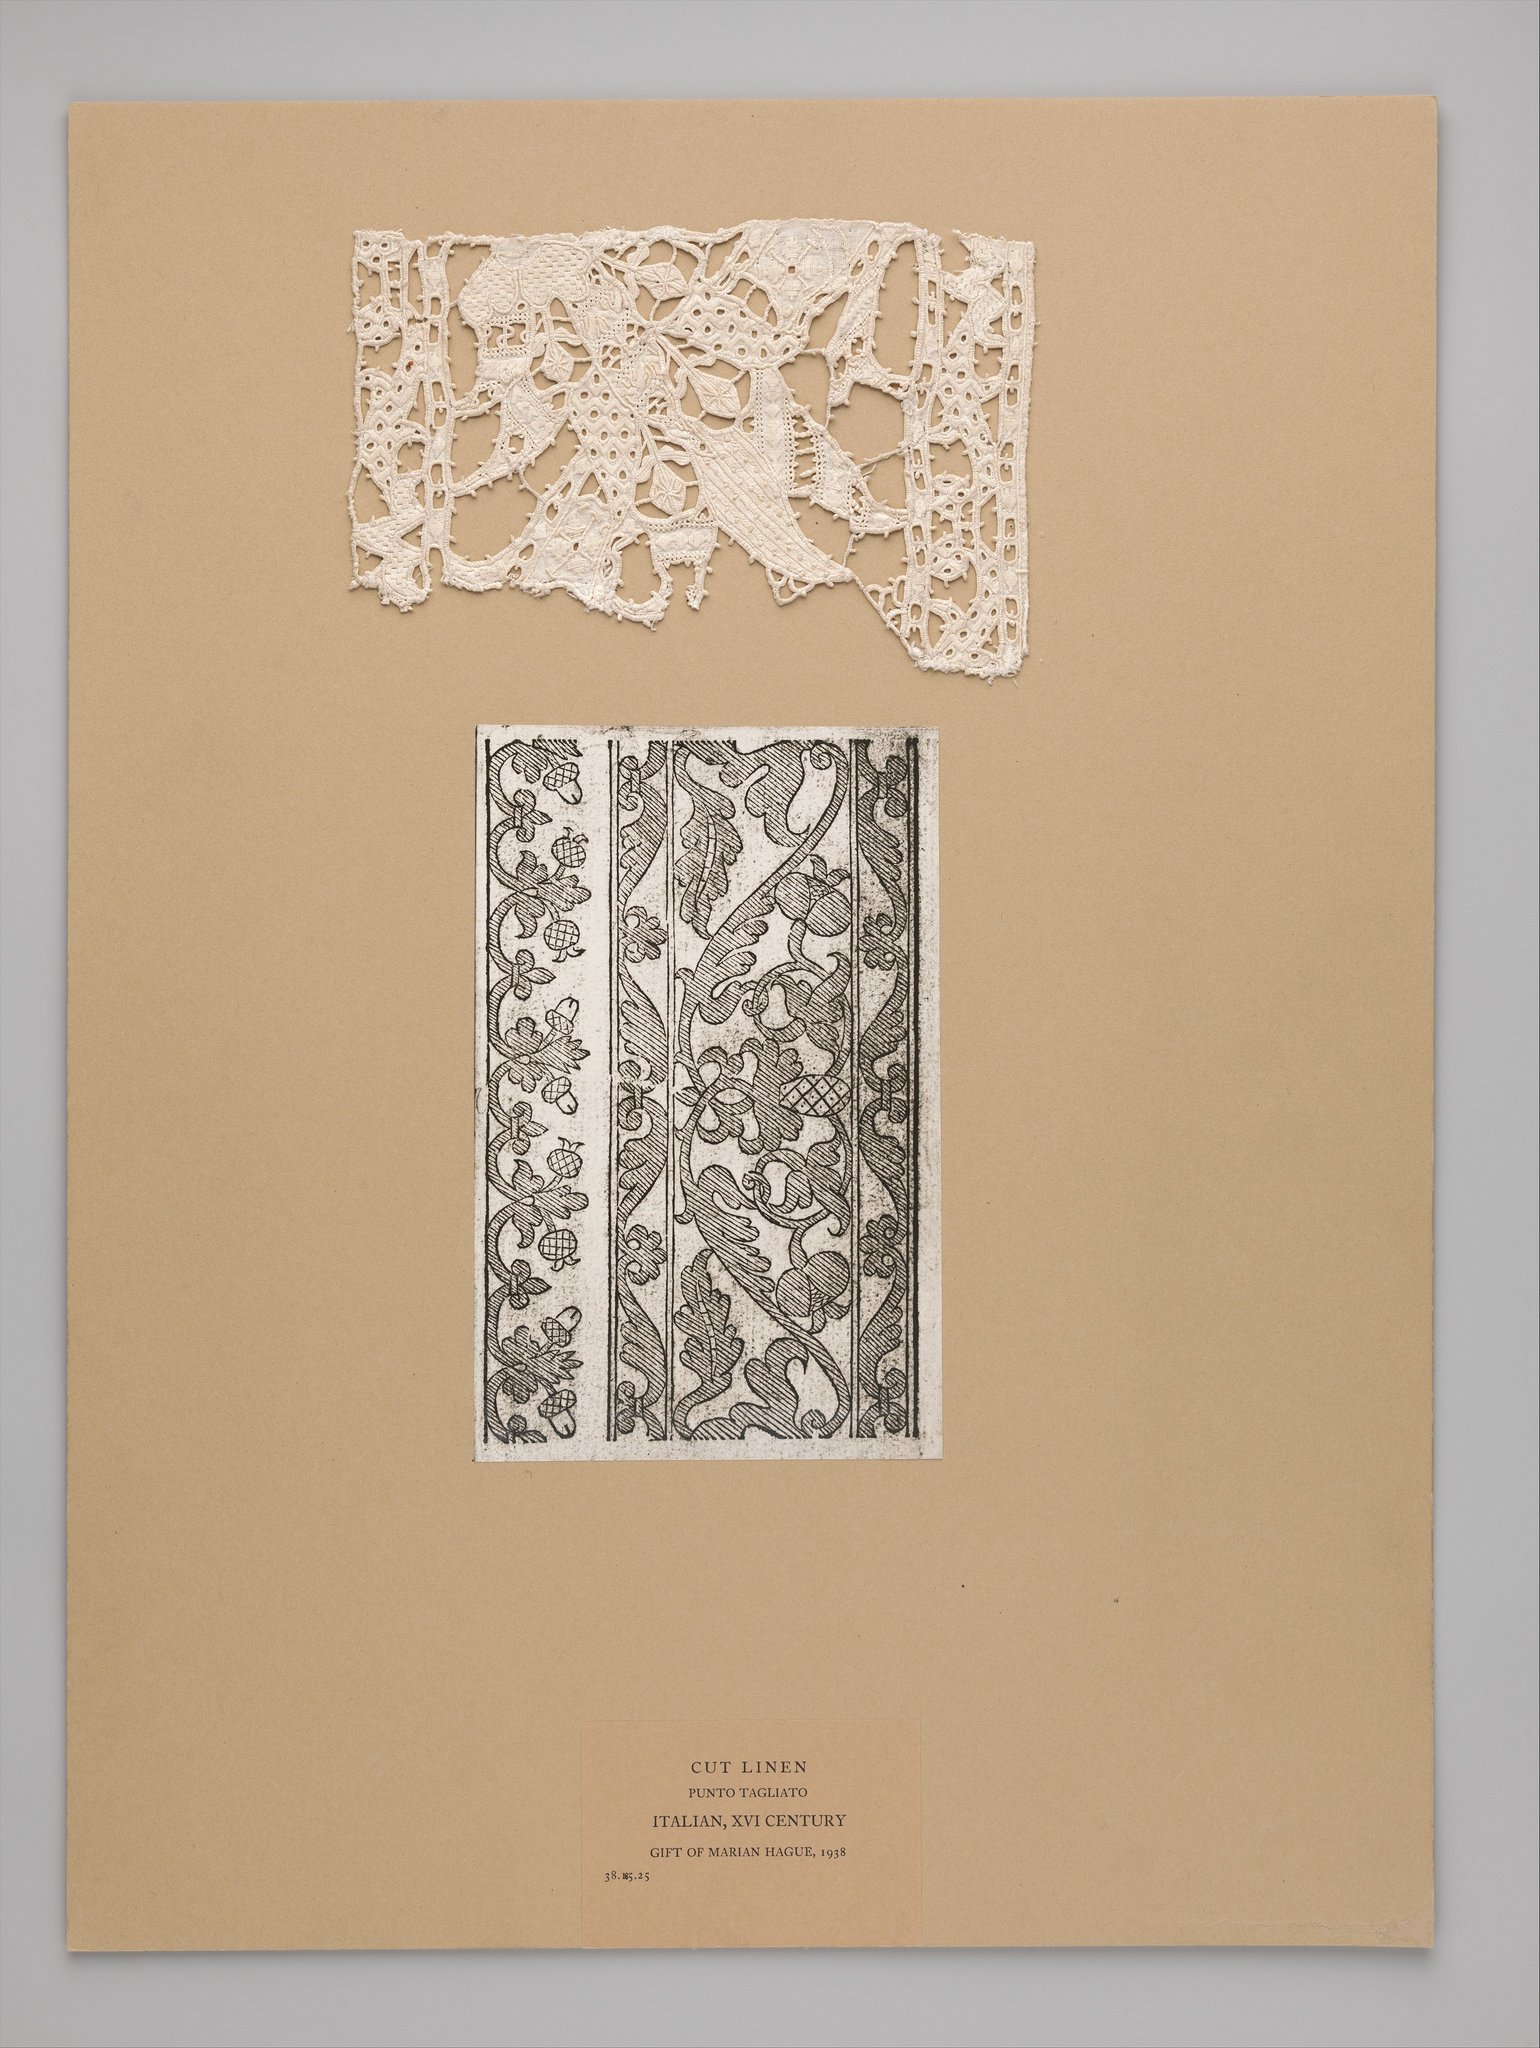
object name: insertion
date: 1501-1600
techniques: embroidery